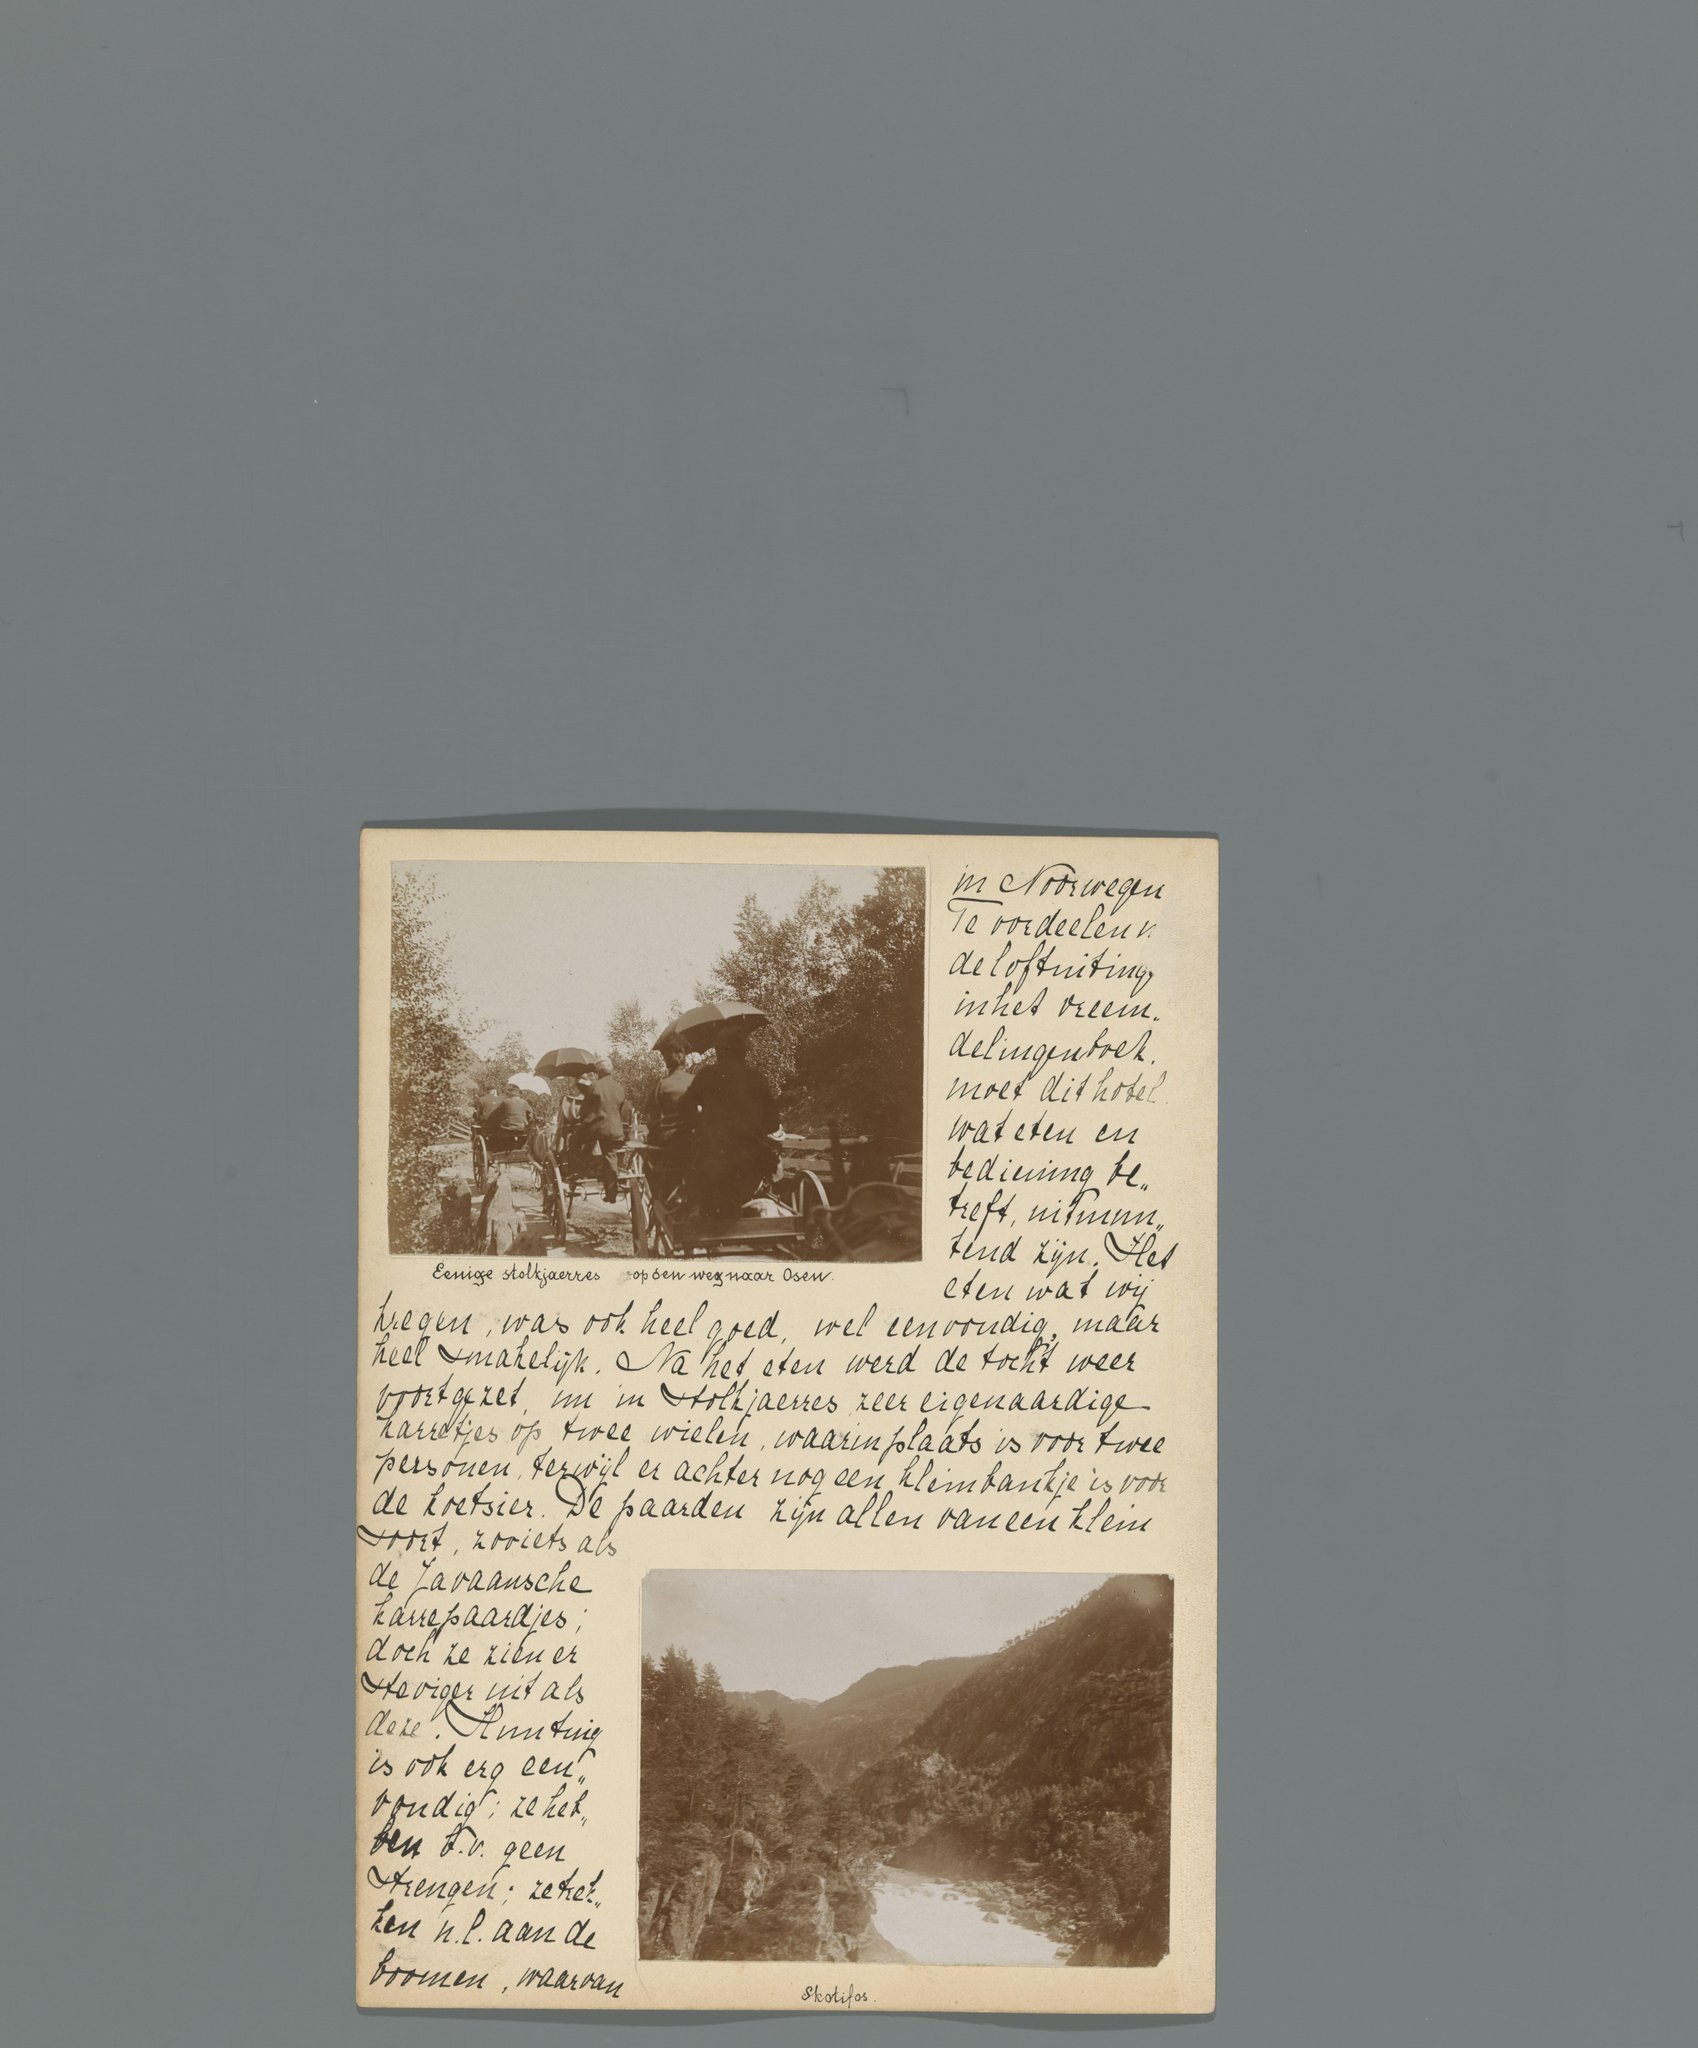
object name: page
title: Tiende pagina van een dagboek van een reis door Noorwegen met twee foto's van koetsen op weg naar Osen en een gezicht op Skotifos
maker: hendrik herman van den berg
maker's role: amateurfotograaf, jurist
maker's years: 1875-1944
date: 1895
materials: paper, ink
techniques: pen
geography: norway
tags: batavia, hendrik herman van den berg, gulf, bay, handwriting, written text, 'en route', traveller under way, two-wheeled vehicle drawn by one animal, mountains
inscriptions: caption: ‘Eenige stokjaerres op den weg naar Osen./ Skotifos.’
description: Tiende pagina van een dagboek met het verslag van een reis door Noorwegen gemaakt door Hendrik Herman van den Berg en zijn neef Guillaume Louis Jacques Holle tussen 5 en 20 juli 1895. Op het dagboekblad zijn twee foto's geplakt met een uitzicht vanuit een koets op weg naar Osen en een gezicht op Skotifos.